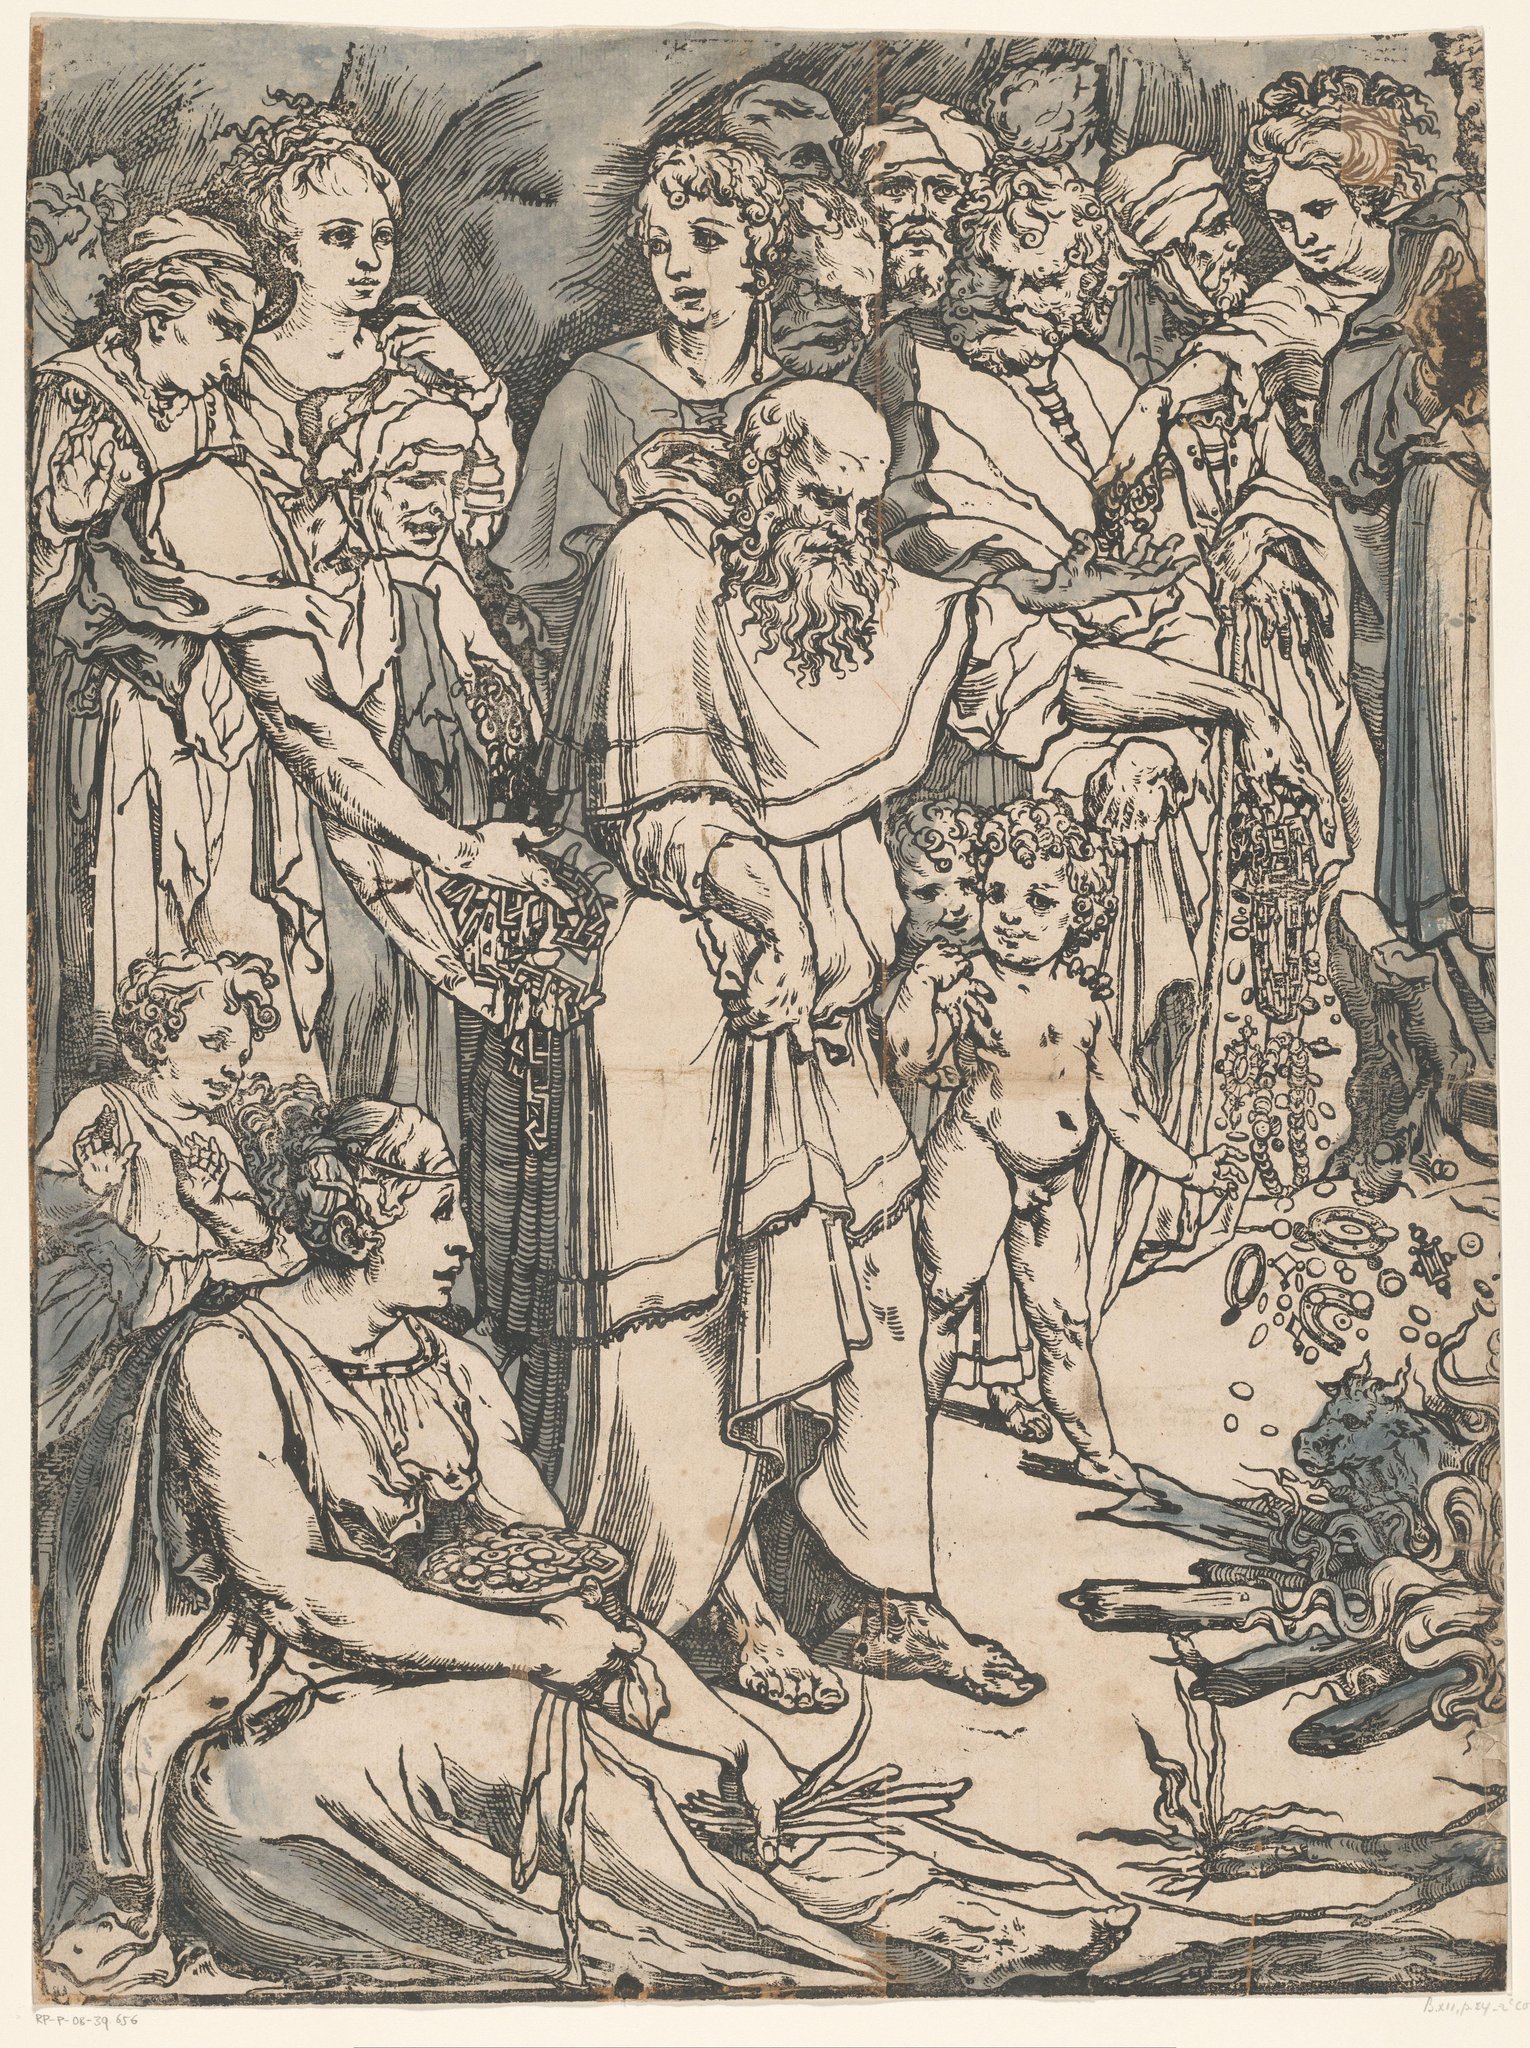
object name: print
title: Mozes breekt de tafelen der wet (eerste deel)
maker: andrea andreani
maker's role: print maker, printer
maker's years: 1558-1629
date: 1590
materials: ink, paper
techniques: brush, hand coloring, pen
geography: siena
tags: on seeing the idolaters moses breaks the tables of the law, the people bring their golden ear-rings to aaron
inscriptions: collector's mark: Lugt 240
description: Mozes houdt een stenen tablet boven zijn hoofd, klaar om het neer te gooien. Rechts het gouden kalf dat vereerd wordt door het volk. Links de Israëlieten die gouden sieraden in het vuur gooit om er het gouden kalf van te smeden.